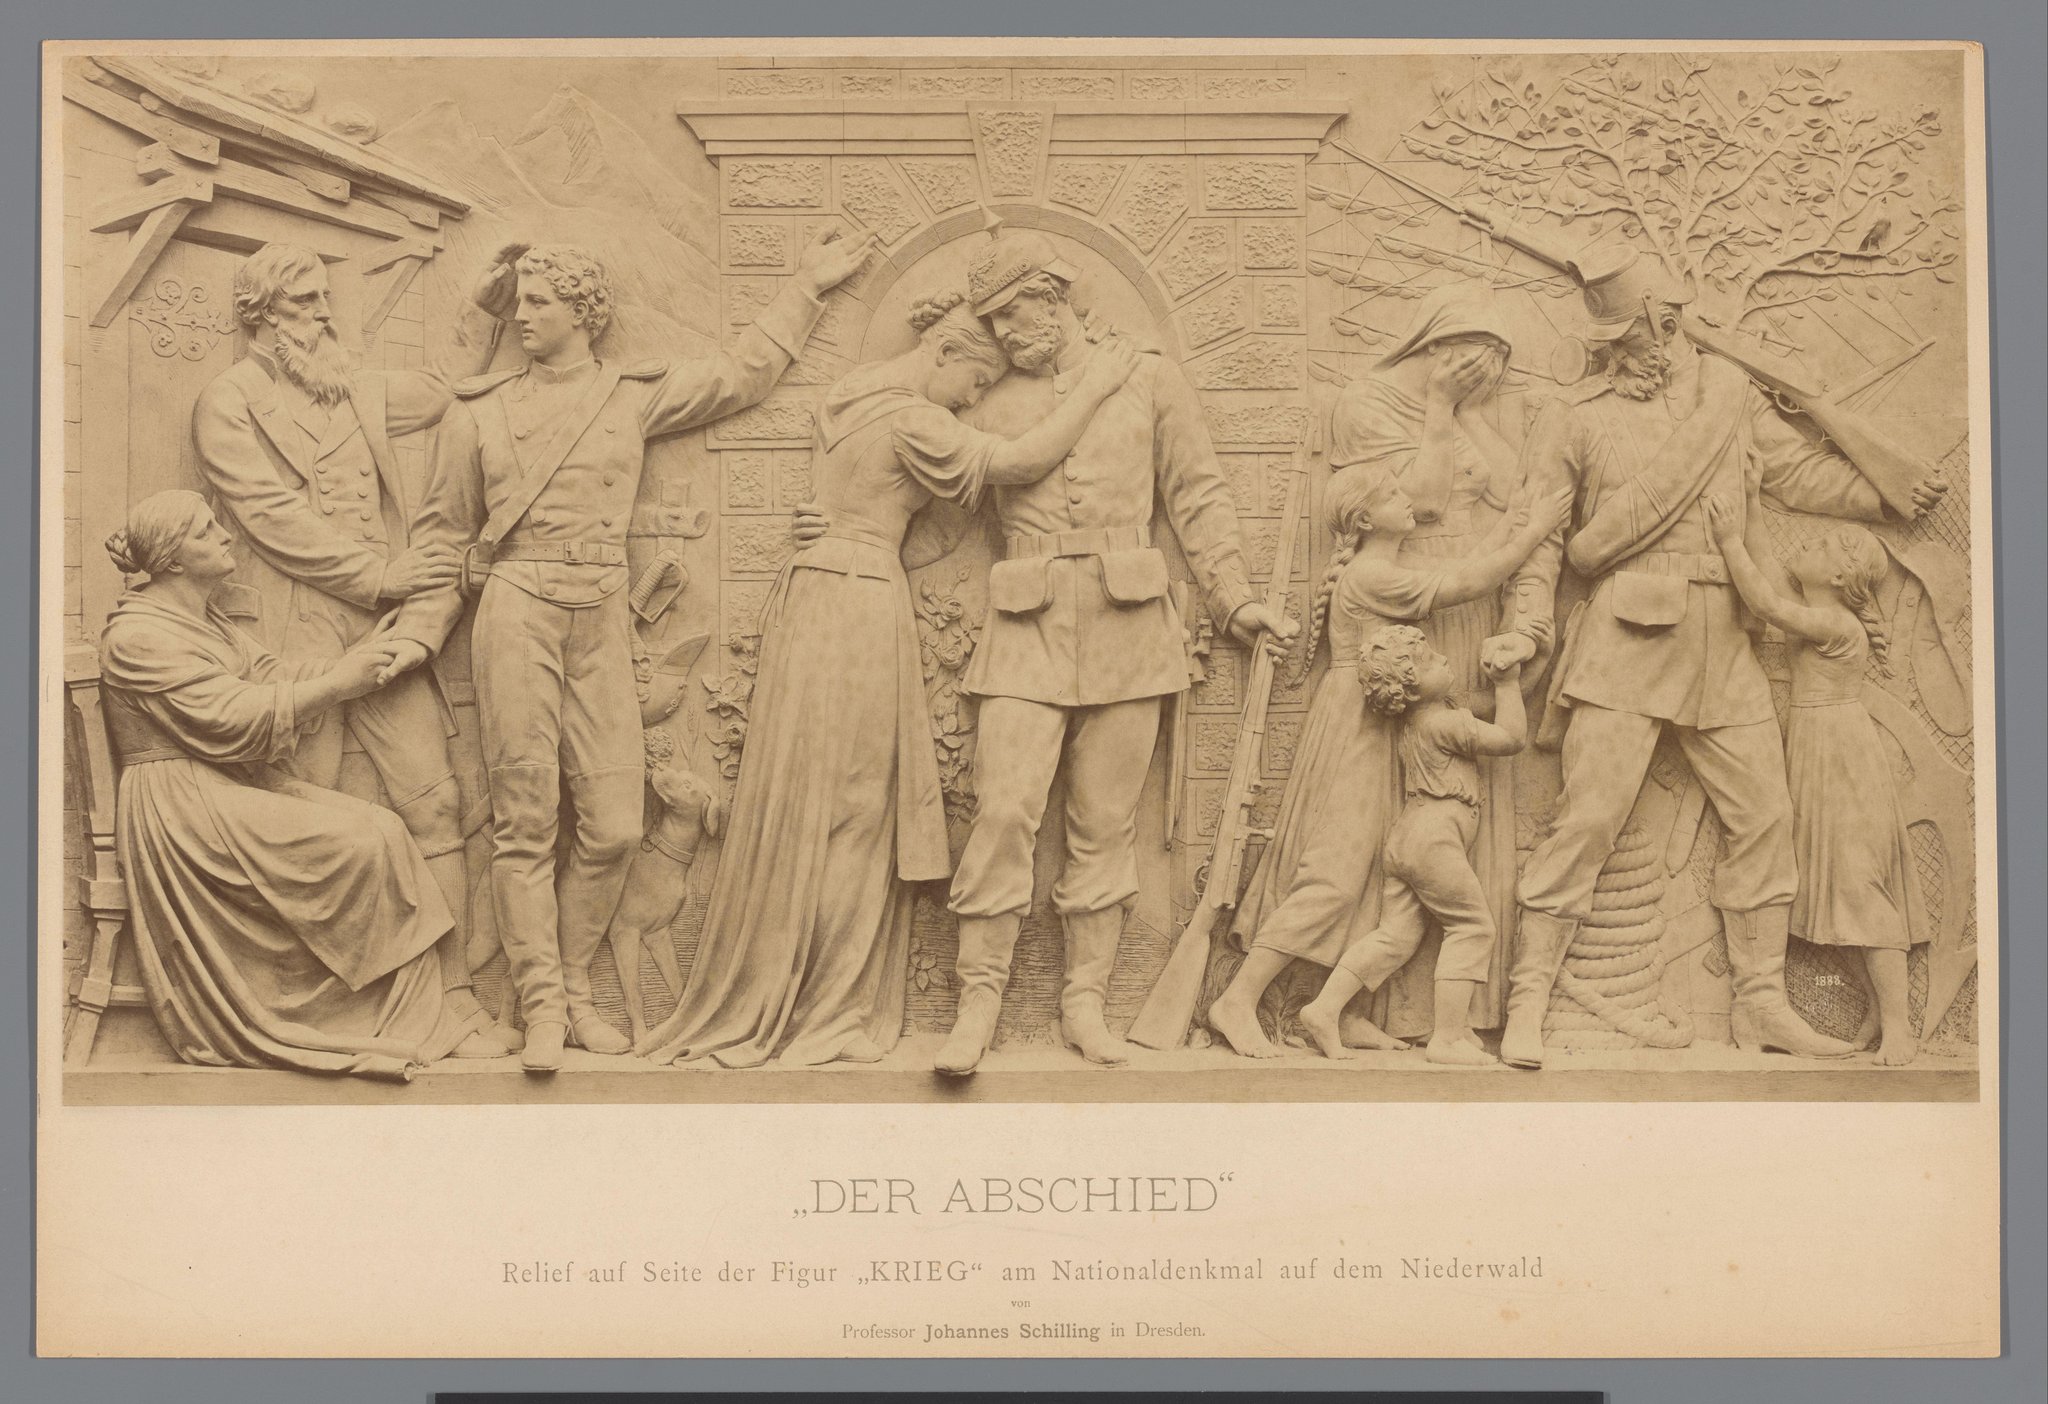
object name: photograph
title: Reliëf van het Nationaal herdenkingsmonument in Niederwald met daarop afscheid nemende soldaten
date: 1887-1920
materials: paper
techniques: albumen print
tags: niederwald, frans-duitse oorlog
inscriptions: number: ‘'16.5’, title: ‘"Der Abschied"Relief auf Seite der Figur "Krieg"am Nationaldenkmal auf dem Niederwald von Professor Johannes Schilling in Dresden’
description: Het National monument op de Niederwald is ogericht na de Frans Duitse oorlog